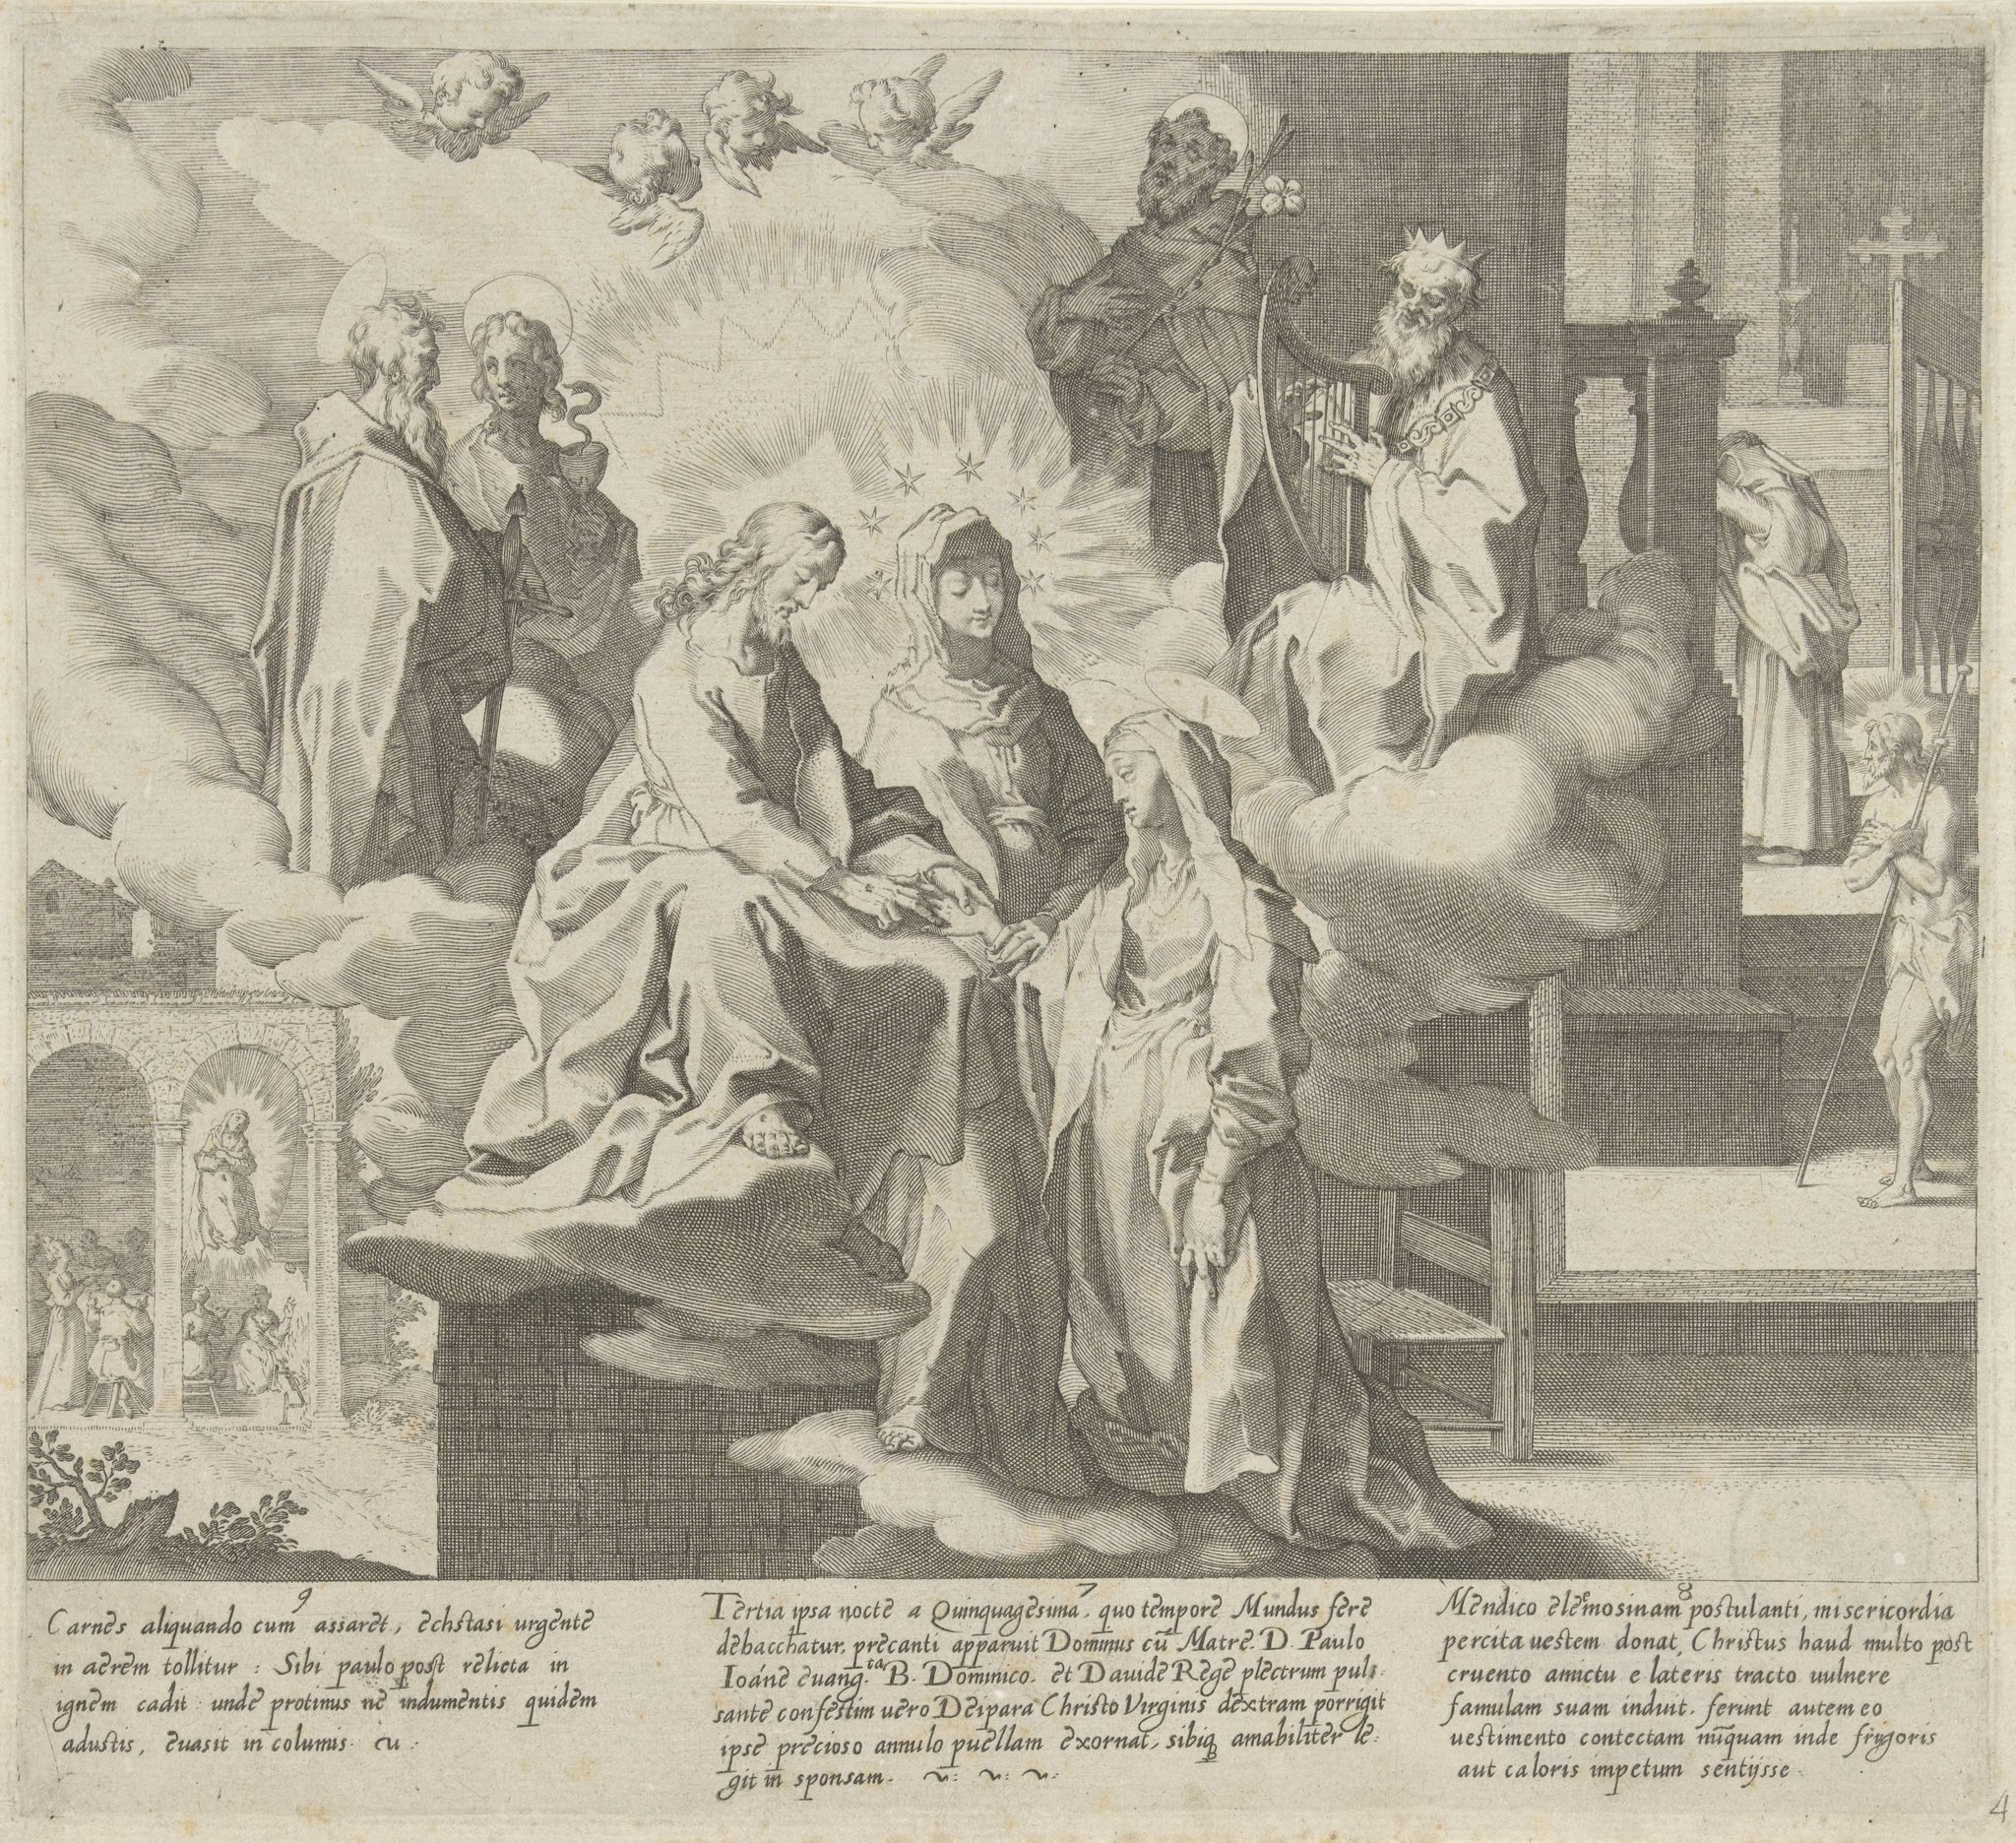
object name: print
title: Vita mors gesta, et miracula quaedam selecta B. CATHERINAE SENENSIS (...)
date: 1597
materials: paper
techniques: engraving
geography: italy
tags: the virgin and dominican tertiary, catherine of siena; possible attributes: book, cross, crown of thorns, crucifix, demon under foot, heart (with cross), lily, plague-stricken, ring, rosary, stigmata, the mystic marriage of st. catherine of siena: she kneels to receive a ring from the infant christ (in mary's lap), or from the adult christ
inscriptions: collector's mark: Lugt 10, collector's mark: Lugt 11, collector's mark: ‘Hinloopen’, inscription: ‘4’